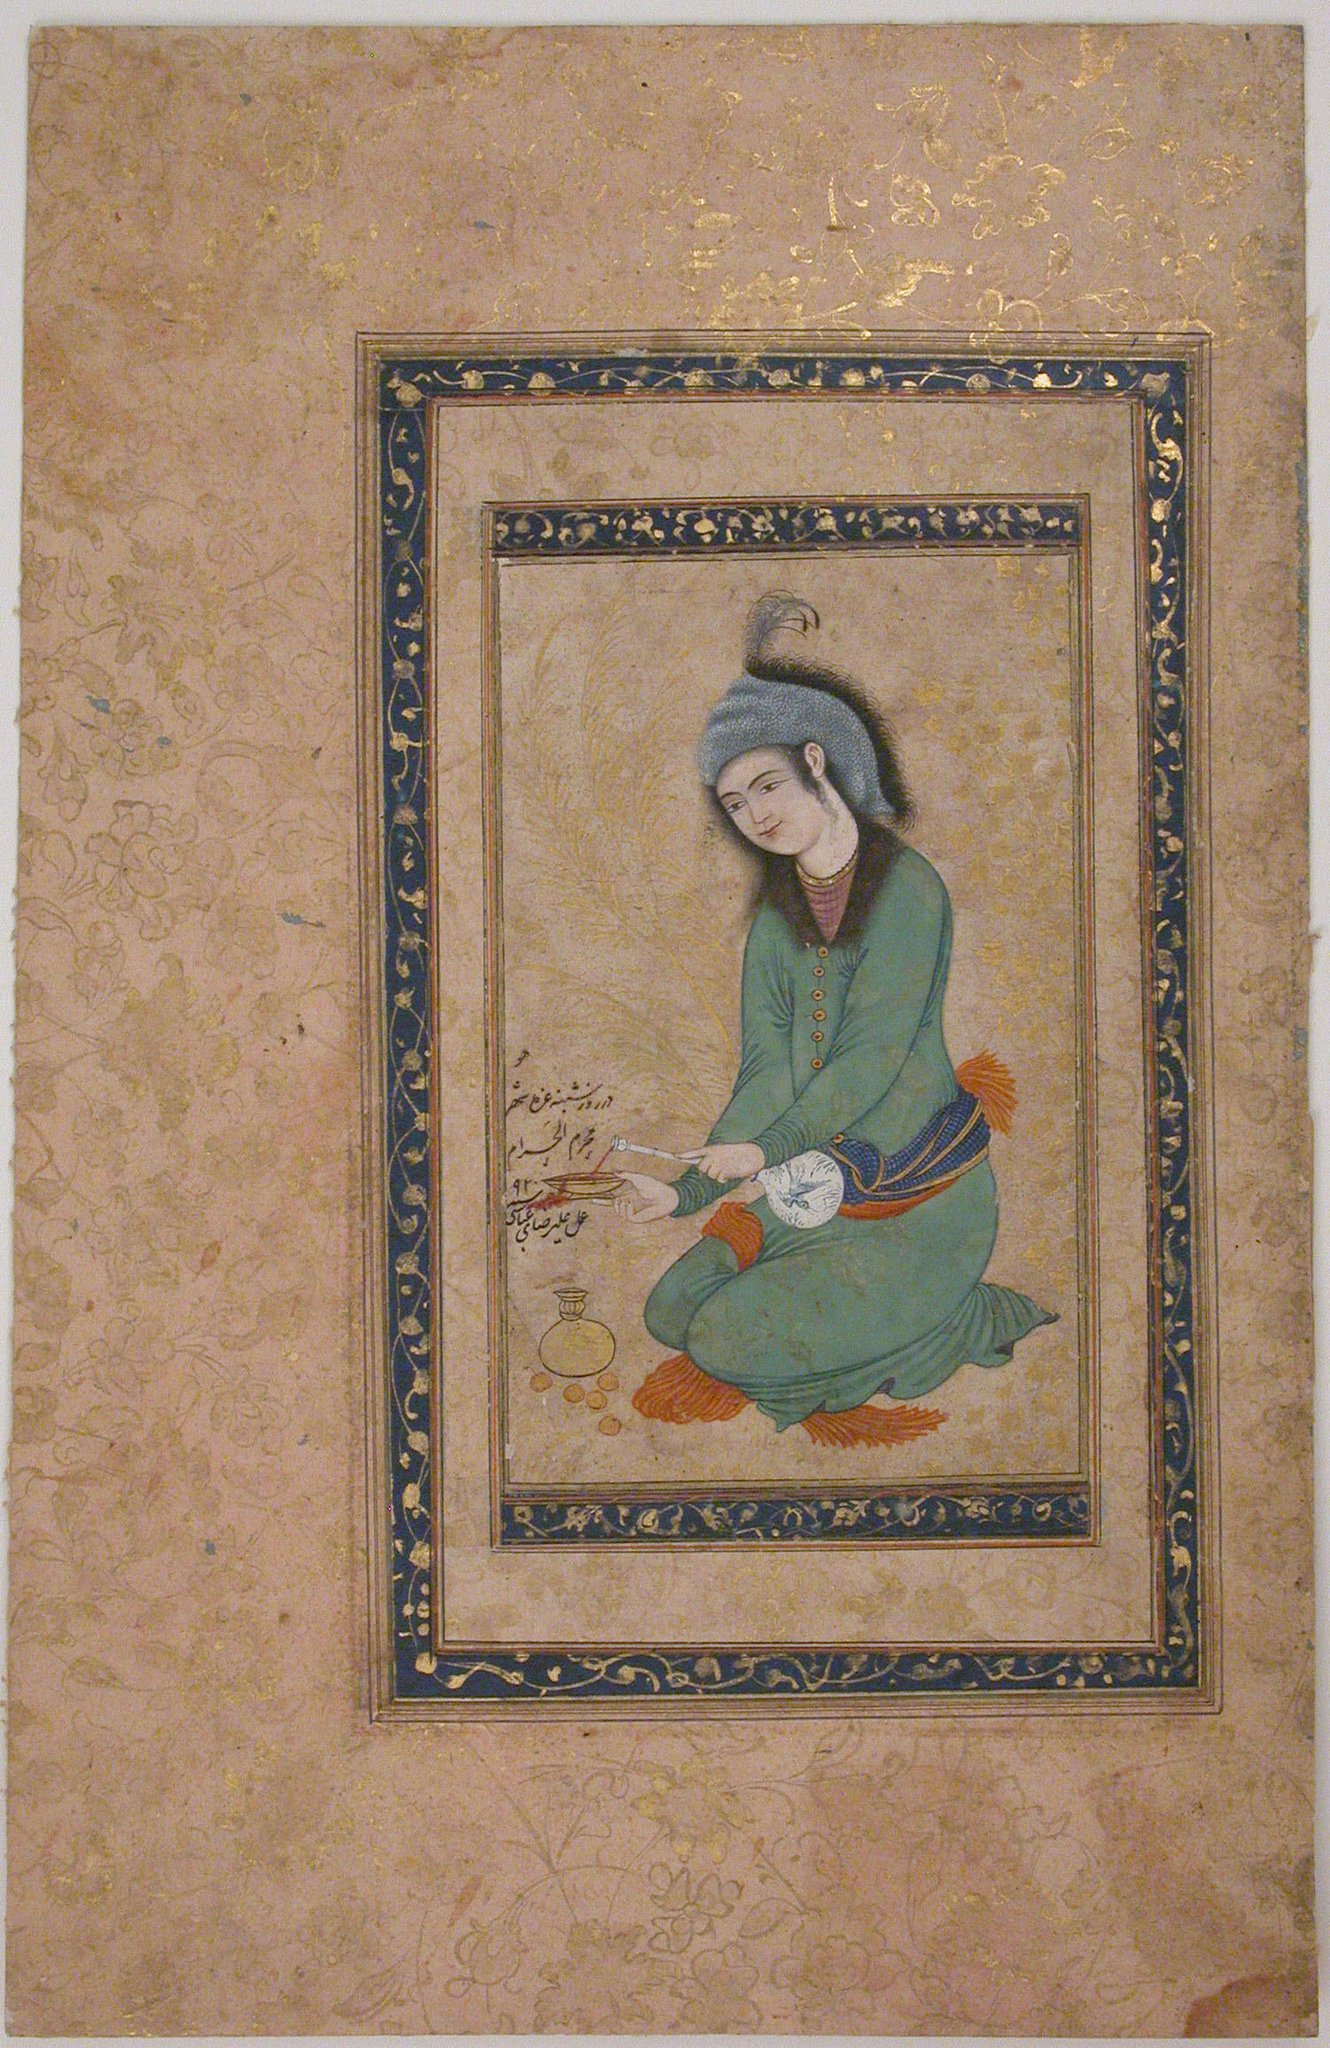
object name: illustrated album leaf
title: Portrait of a Youth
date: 1601-1700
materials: gold, paper, watercolor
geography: iran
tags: portraits